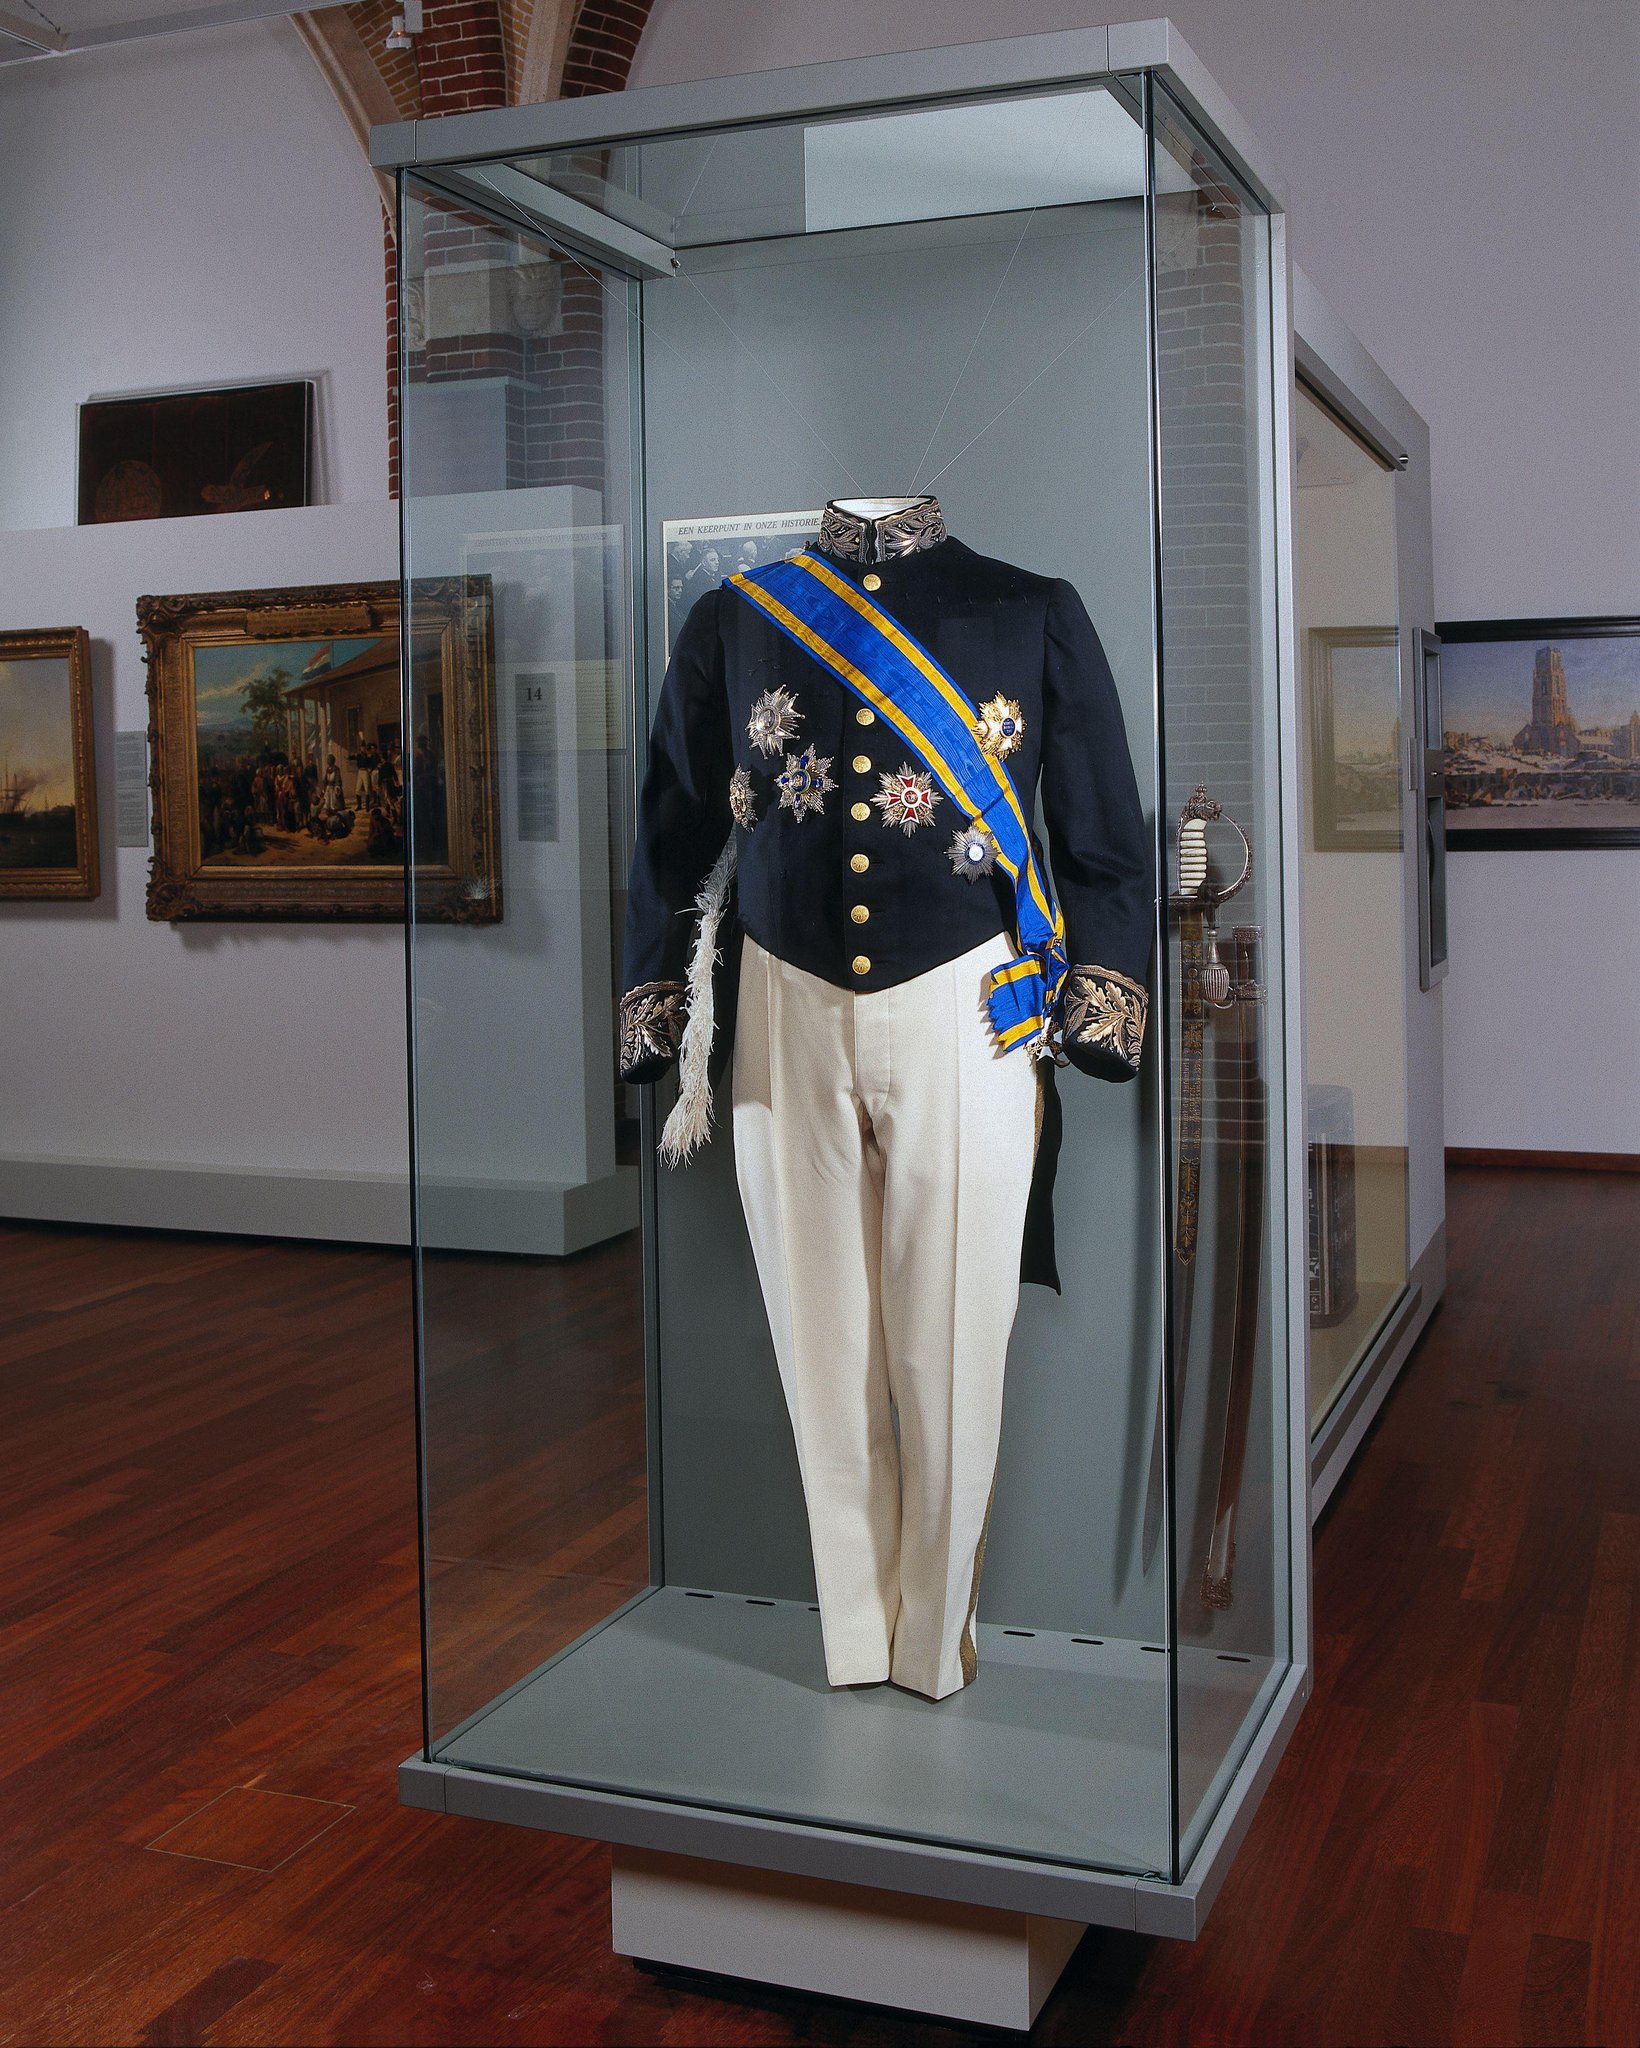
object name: menswear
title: Boord van ambtskostuum van Hendrikus Colijn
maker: Anonymous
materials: cardboard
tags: hendrikus colijn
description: H. Colijn's ministerial uniform and sabre. Sabre of silver and ivory, sheath of nickel-plated steel. Hendrikus Colijn (1869-1944) began his career as a soldier in the Dutch East Indies. As a veteran of the 1894 Lombok campaign he was awarded the Militaire Willemsorde. In 1899, following his participation in the Atjeh campaign, he was presented with this honourary sabre. In 1904 he was appointed adjutant to Governor General Van Heutsz. Back in the Netherlands (1909), Colijn entered parliament as an Anti-Revolutionary (1909-1911). He served as minister of war (1911-1913), head of the Bataafsche Petroleum Maatschappij (1914-1922), minister of finance (1923-1925) and prime minister (1925 and 1933-1939). His drastic economic cuts during the Depression met with deep resentment. Although not the original decorations, these are identical to those awarded to Colijn.